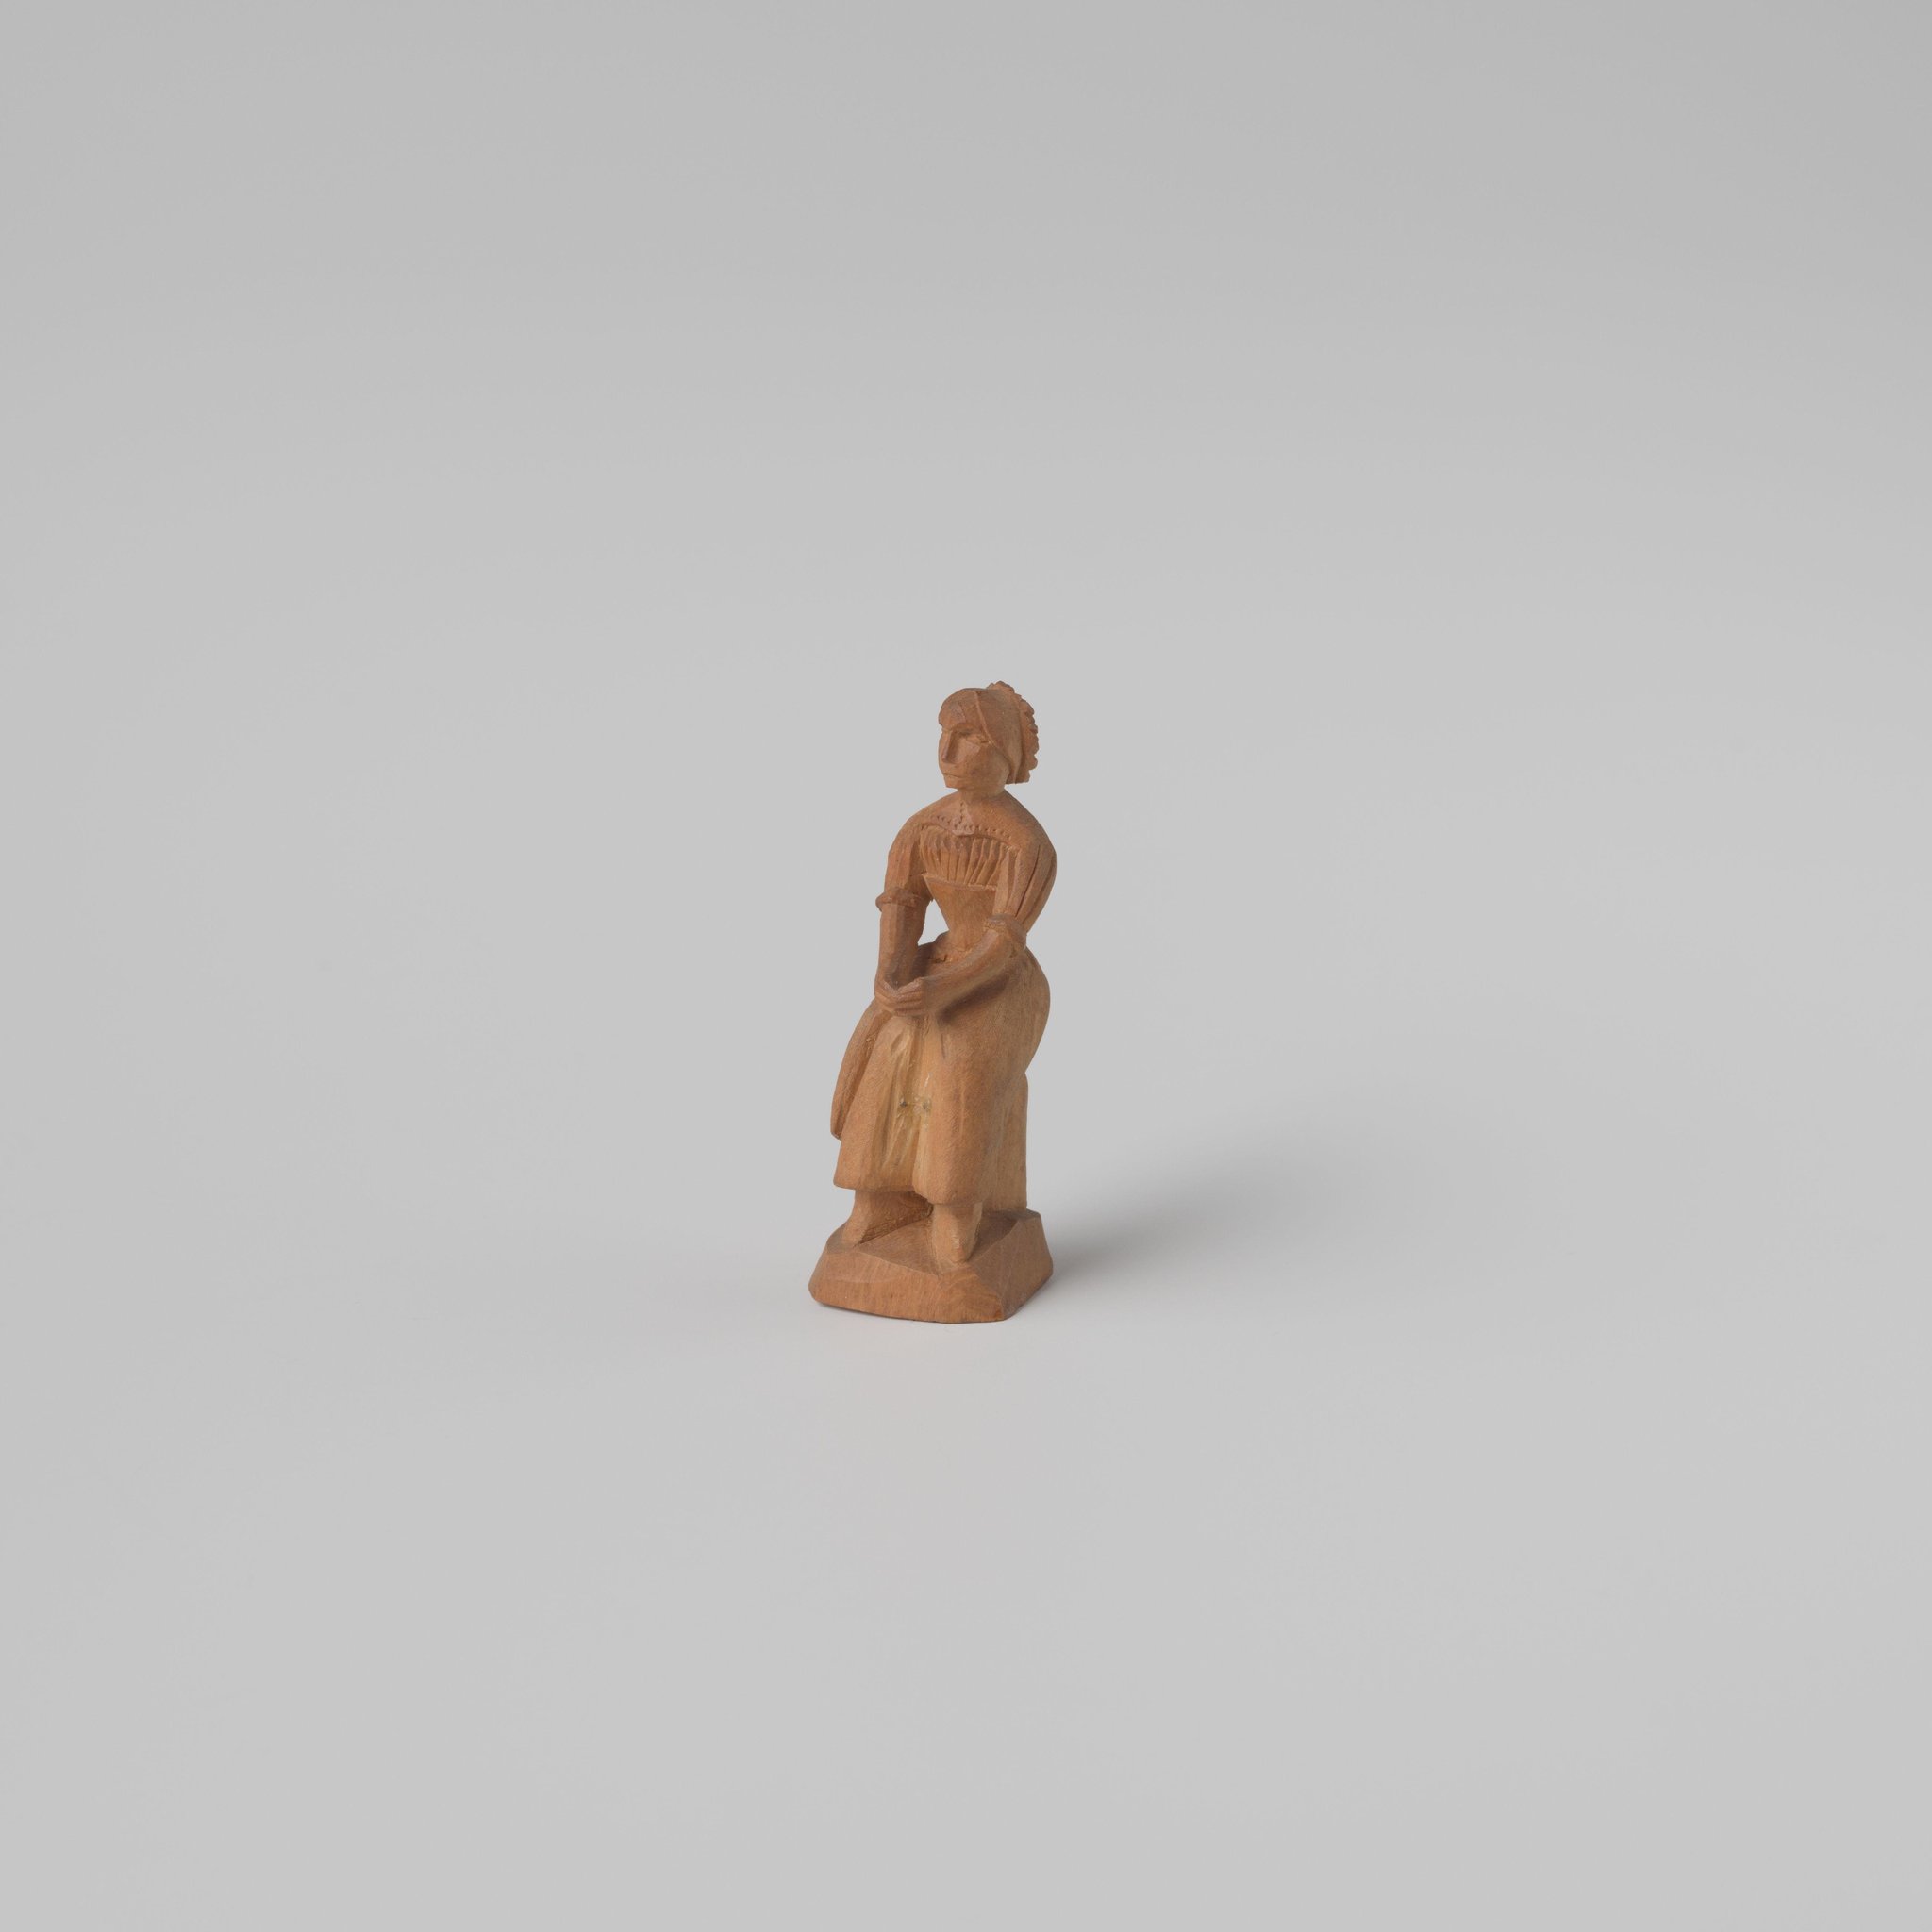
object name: decoratief object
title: Beeld van een zittende vrouw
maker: Anonymous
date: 1800-1900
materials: wood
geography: germany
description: Beeld van een zittende vrouw, de handen gevouwen op schoot.